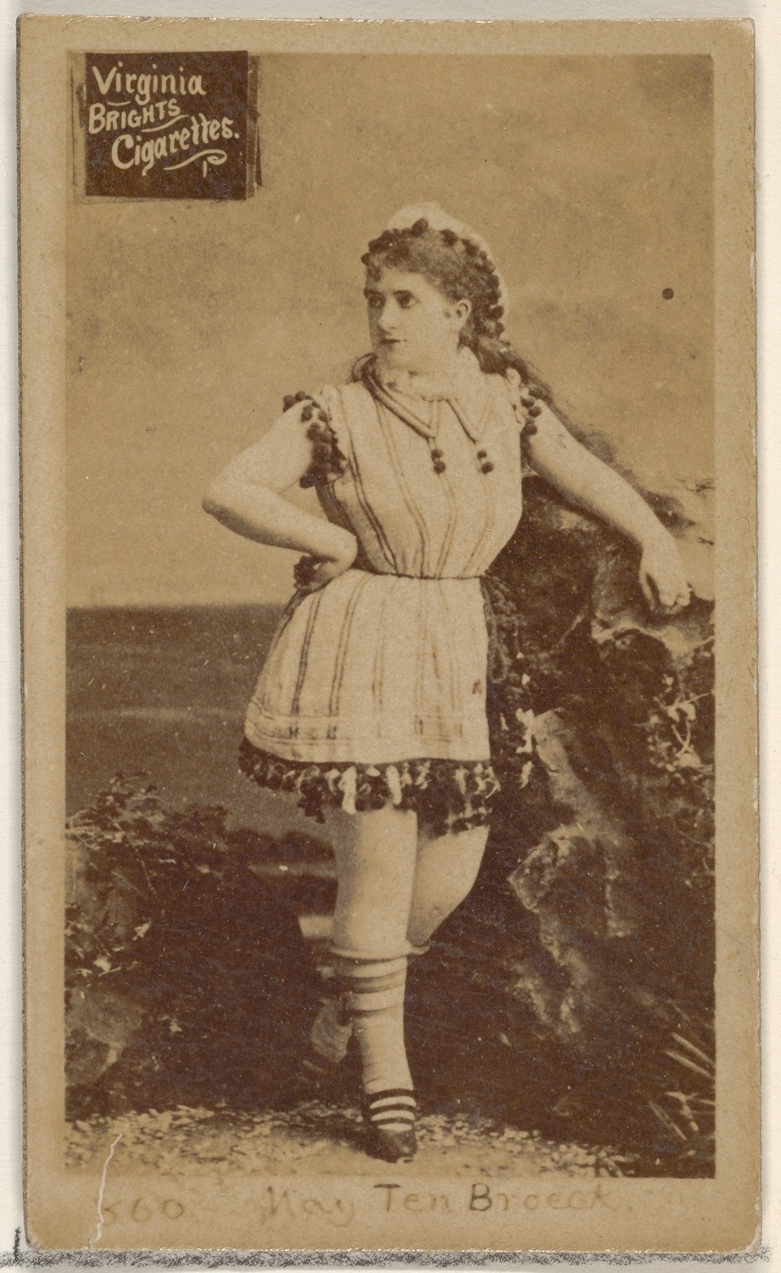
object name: photograph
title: Card 860, May Ten Broeck, from the Actors and Actresses series (N45, Type 2) for Virginia Brights Cigarettes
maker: allen & ginter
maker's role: publisher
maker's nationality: american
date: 1888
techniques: albumen silver print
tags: portraits,women,actresses